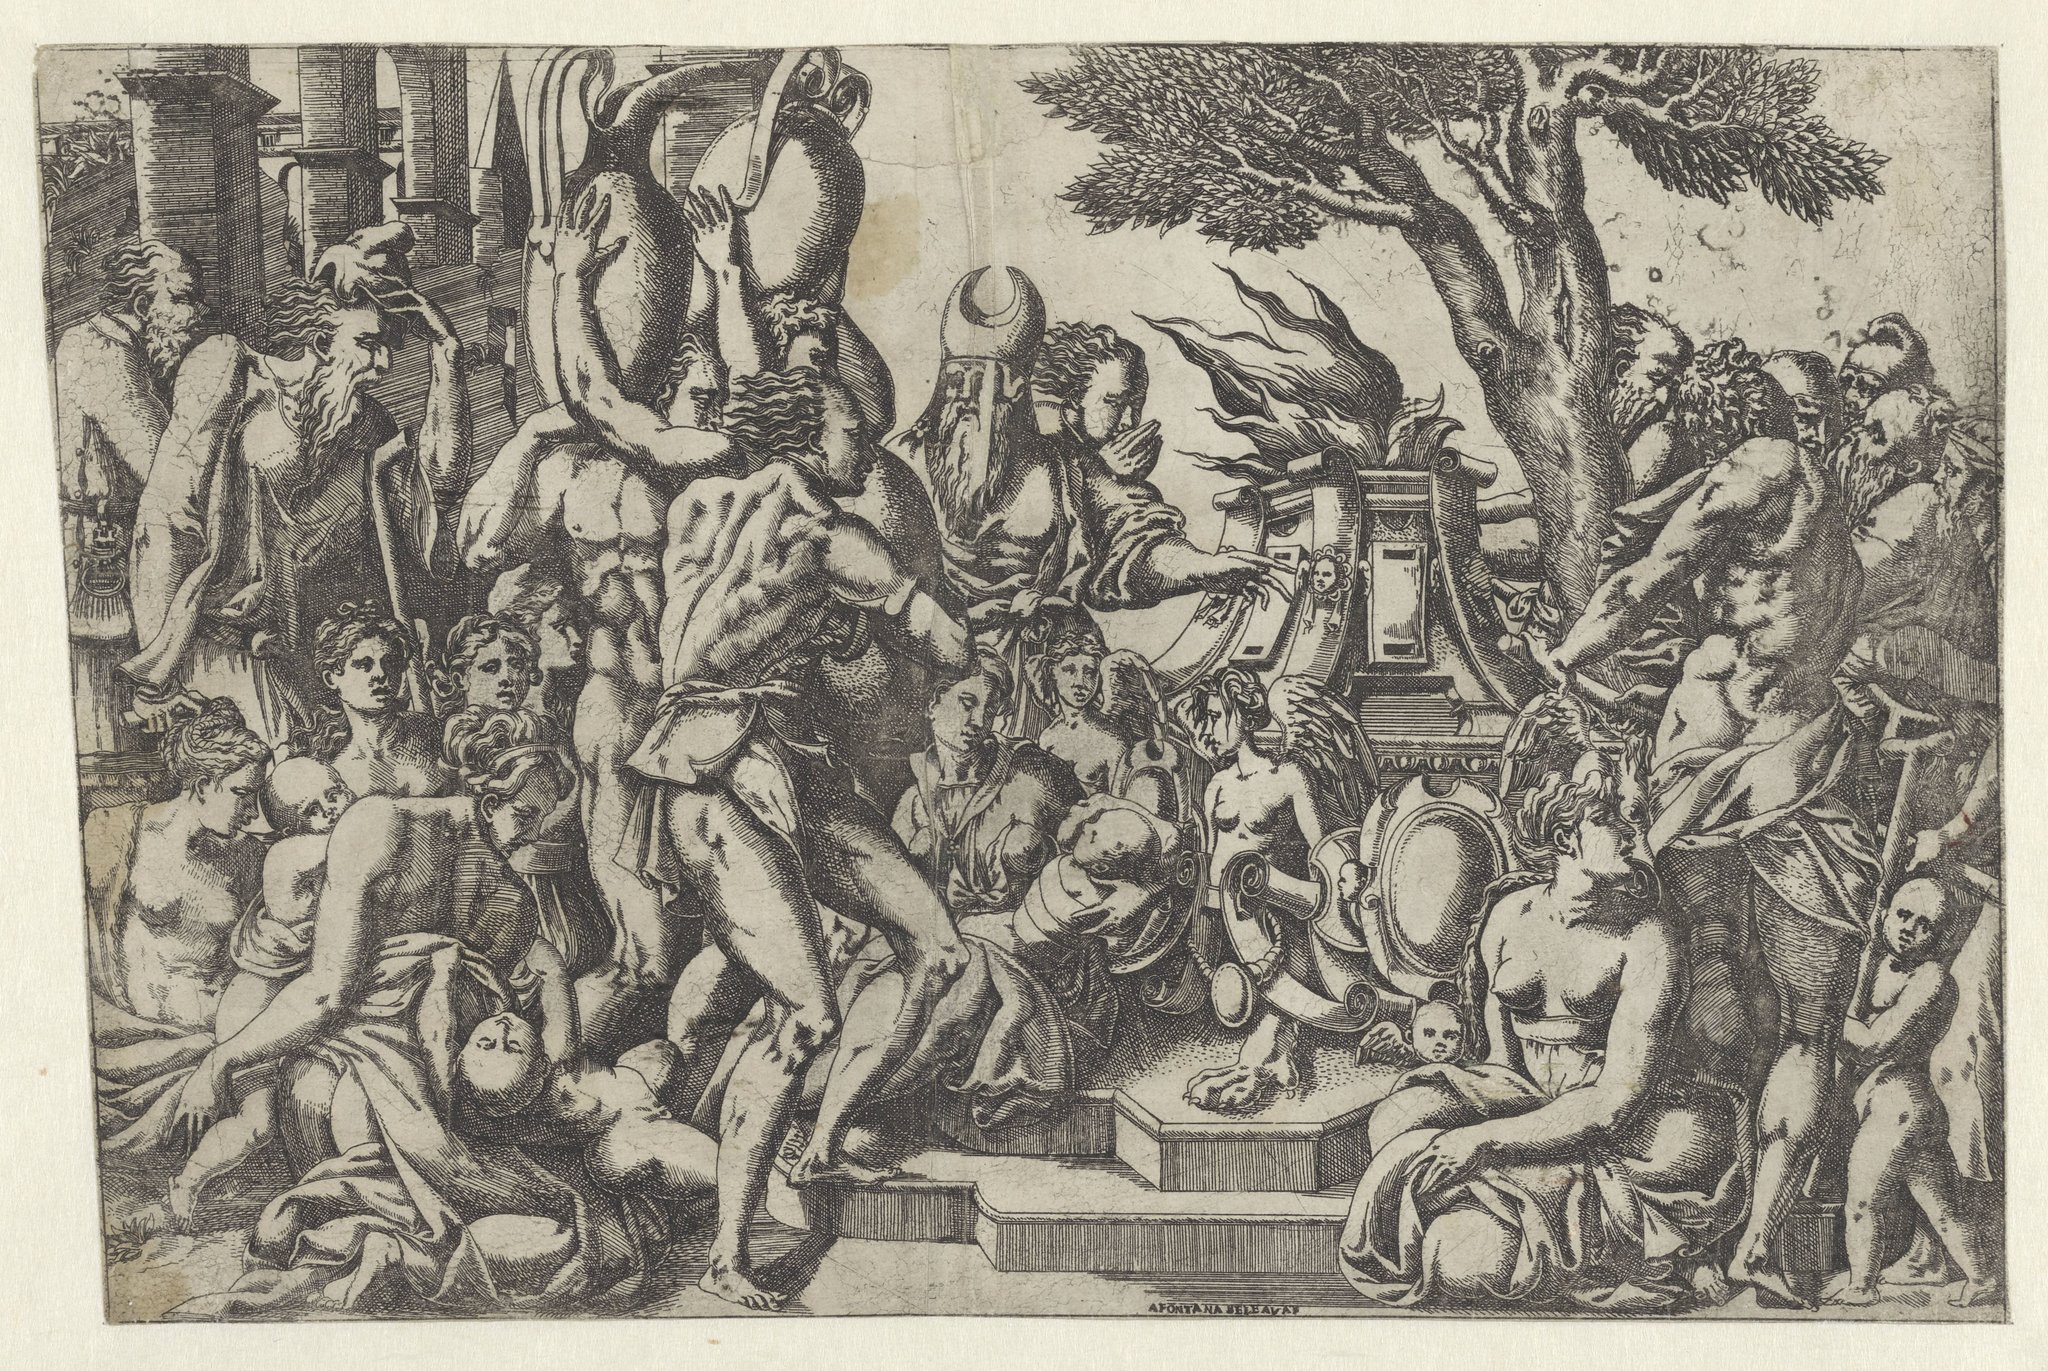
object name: print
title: Offerscène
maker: antonio fantuzzi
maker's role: painter, print maker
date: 1542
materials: paper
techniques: etching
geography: fontainebleau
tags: sacrifice ~ non-christian religions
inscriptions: collector's mark: Lugt 240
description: Een grote groep mannen, vrouwen en kinderen rond een altaar met een offervuur. Naast het altaar staat de priester.